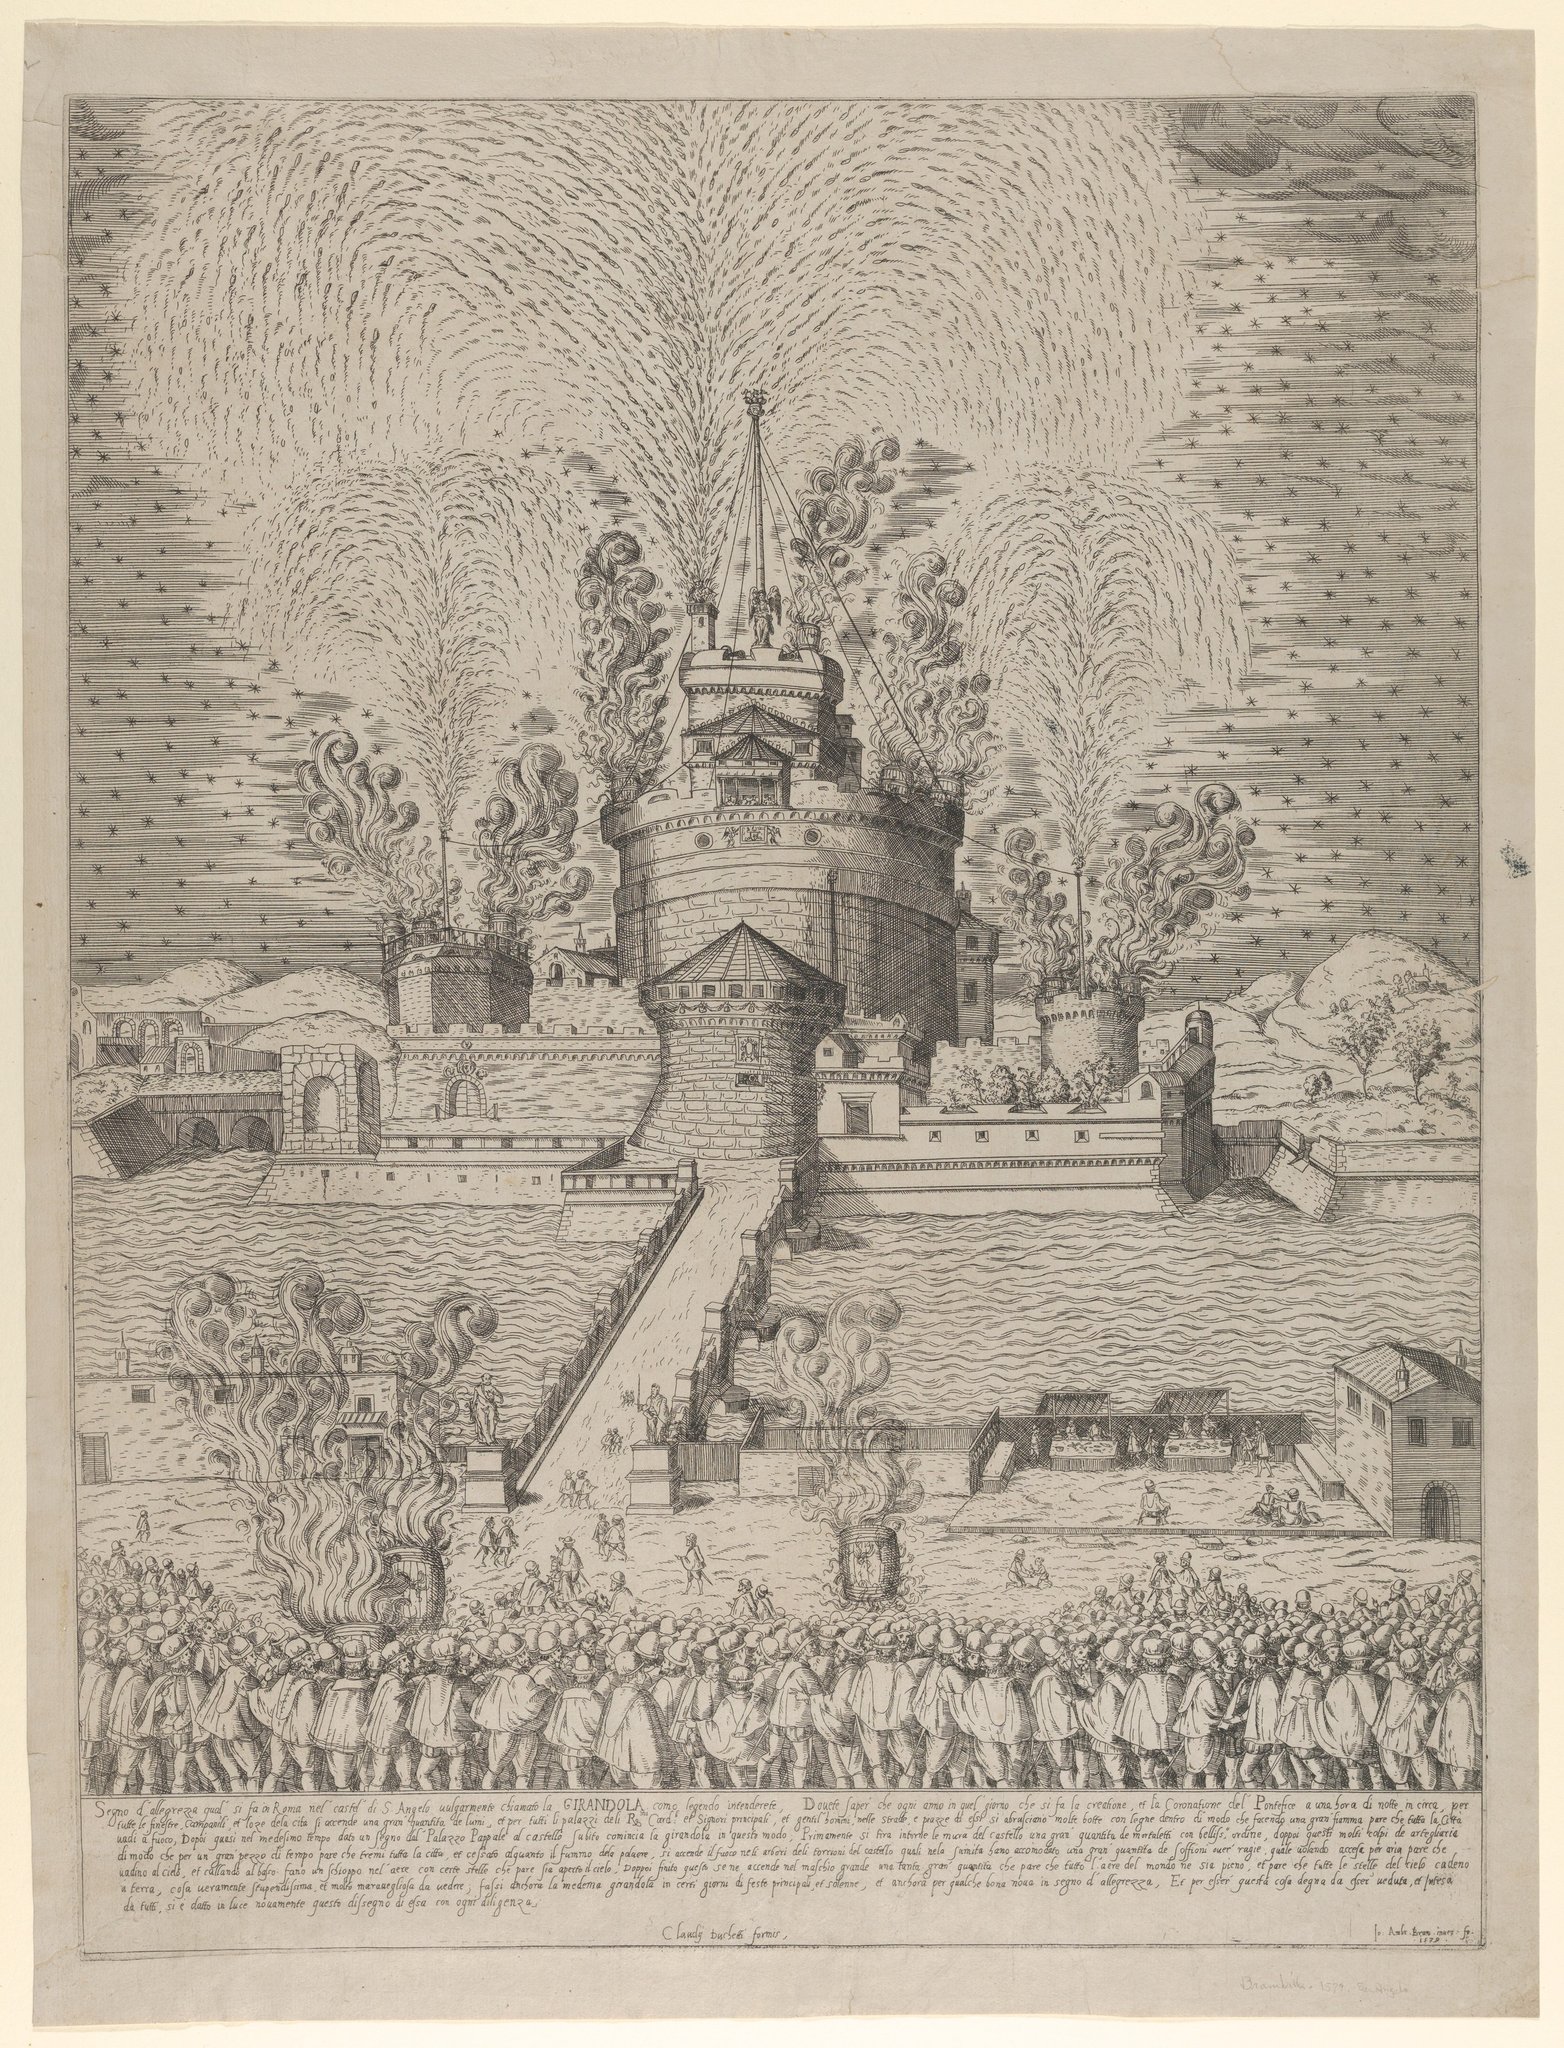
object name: print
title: The firework display called 'Girandola' at the Castello Sant'Angelo in Rome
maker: giovanni ambrogio brambilla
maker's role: artist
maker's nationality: italian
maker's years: 1575-1599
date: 1579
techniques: engraving, etching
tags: castles,fireworks,crowd